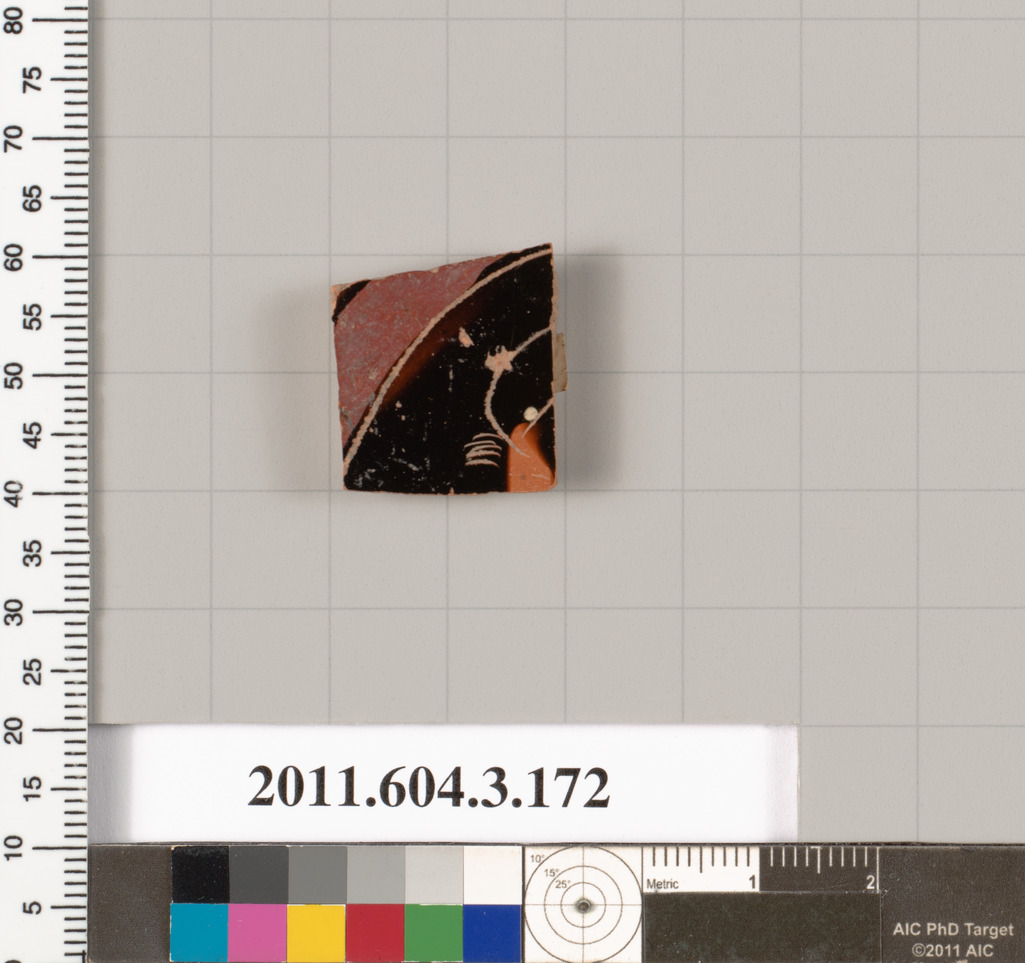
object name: amphora fragment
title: Terracotta fragment of an amphora (jar)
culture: greek, attic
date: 540-530 BCE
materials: terracotta